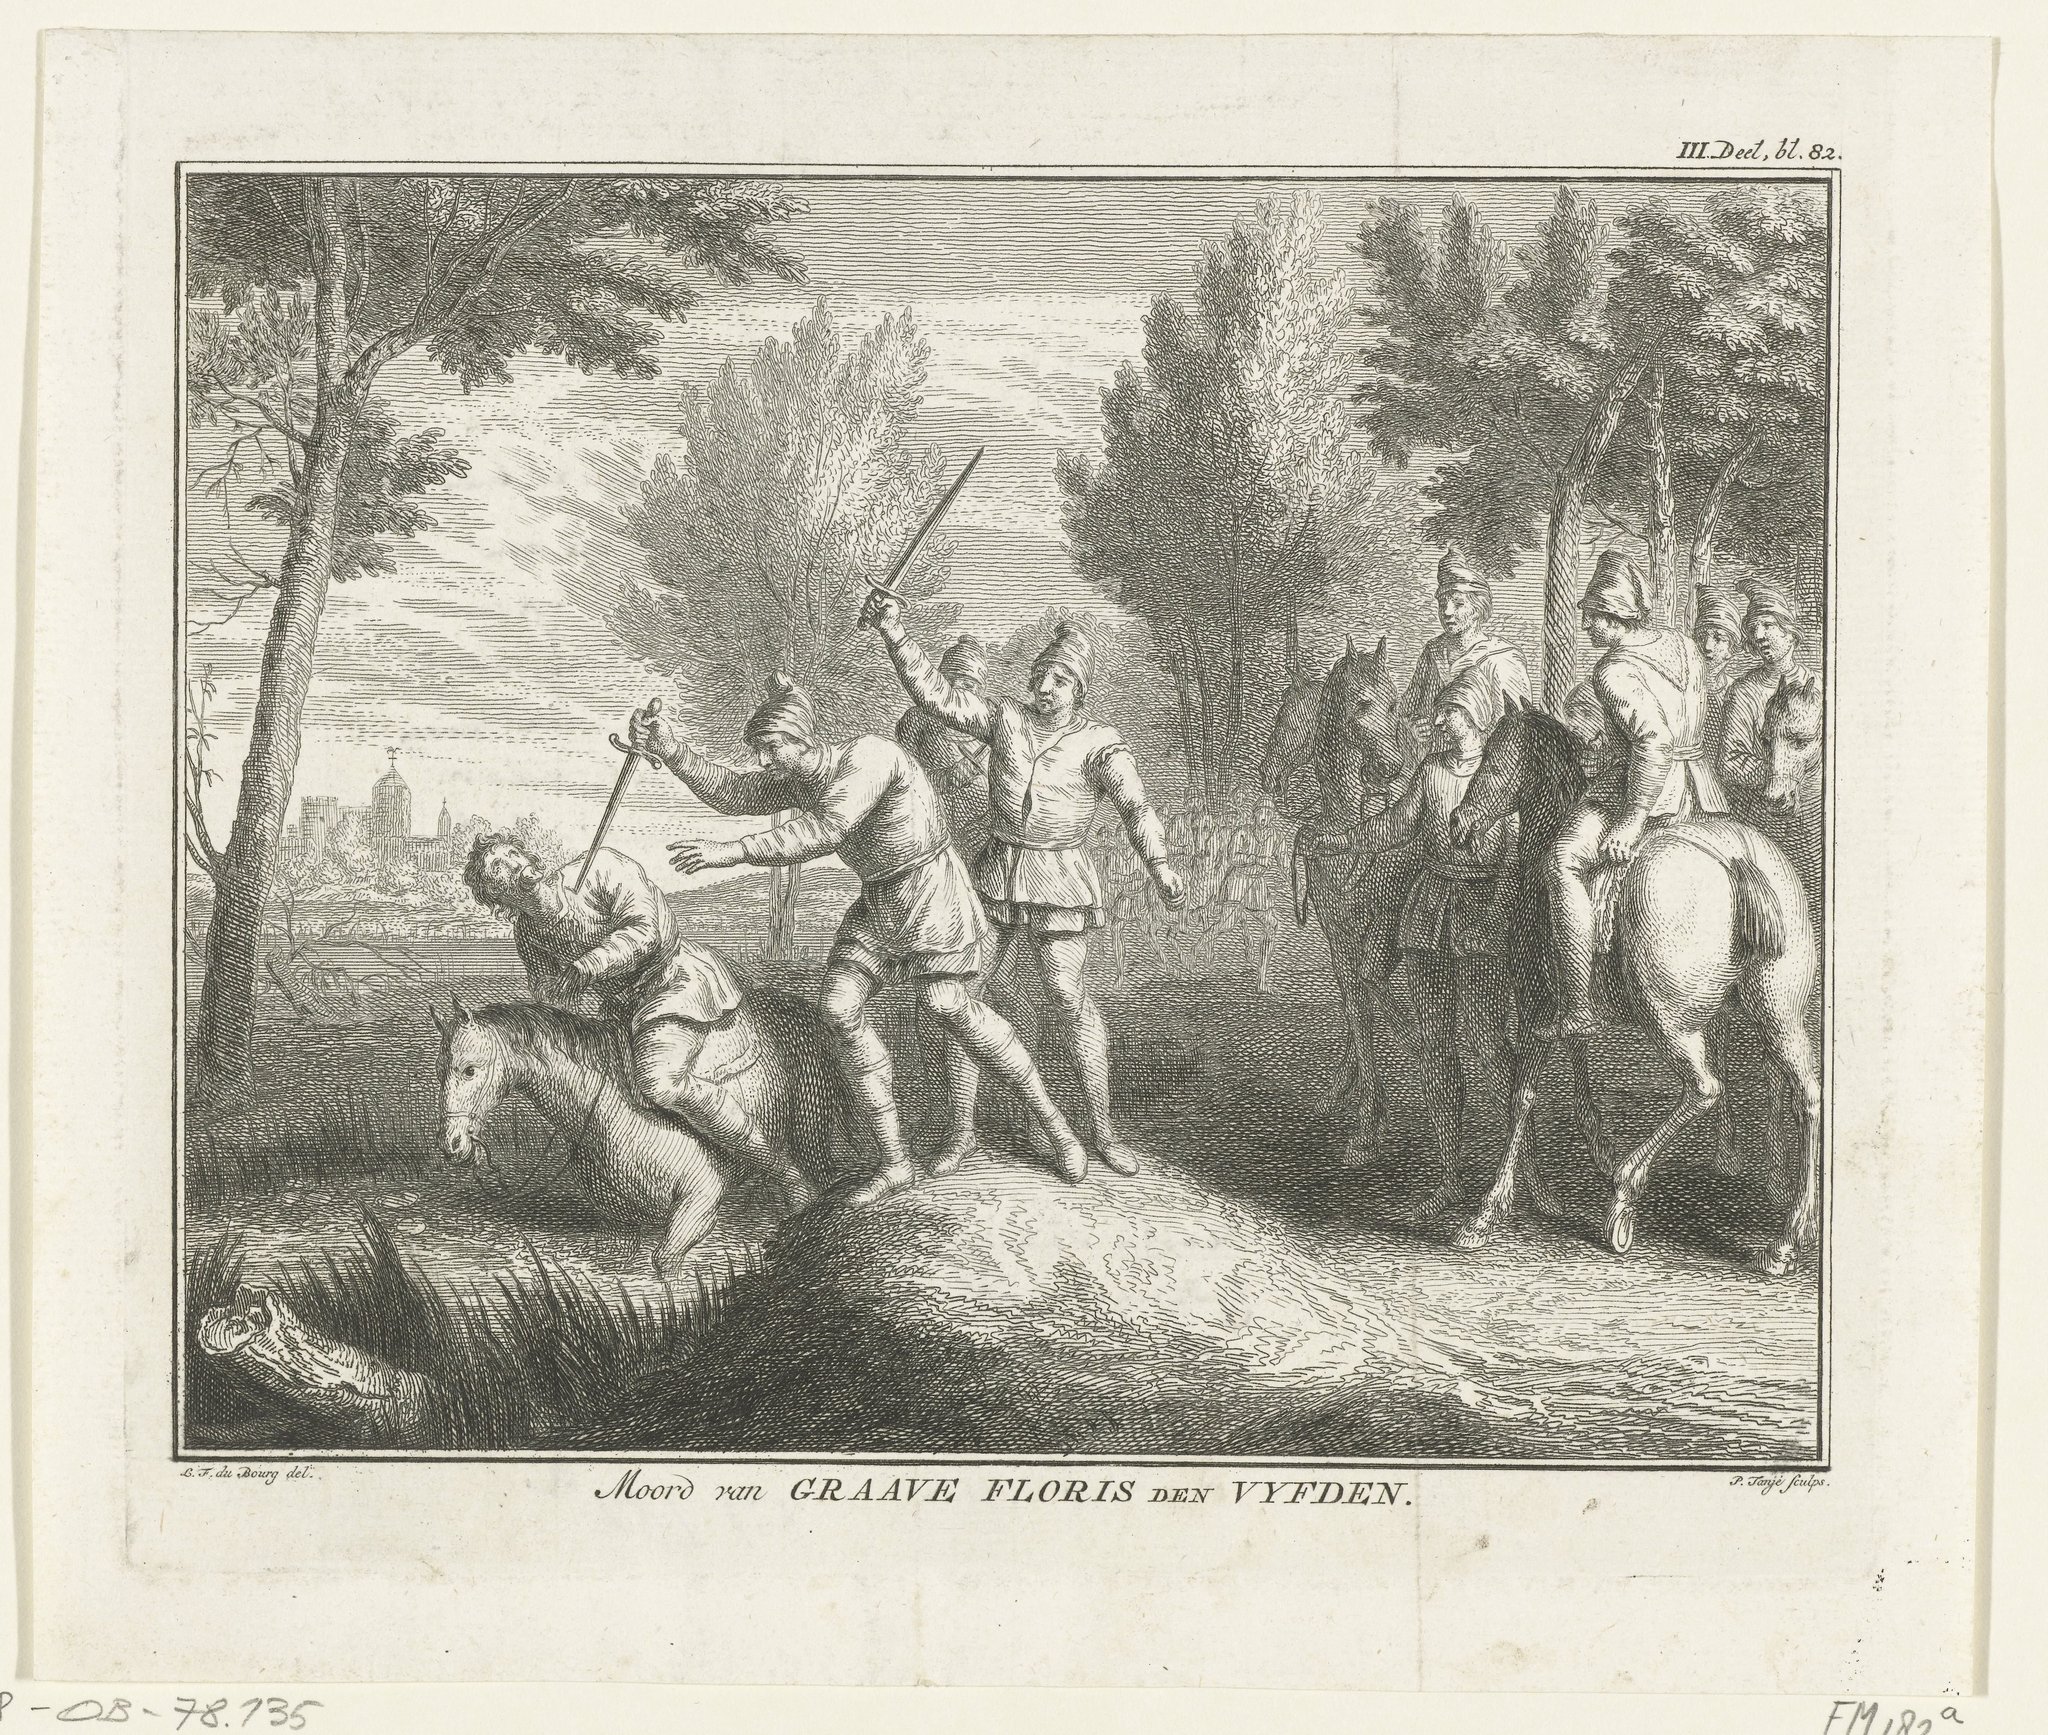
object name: print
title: Moord van Graave Floris den Vyfden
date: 1747-1759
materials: paper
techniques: etching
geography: northern netherlands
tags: leiden, floris v (graaf van holland en zeeland), violent death, being killed; being mishandled and maltreated; seeking death, netherlands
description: Floris V vermoord door Gerard van Velzen, 26 juni 1296. De graaf die vastgebonden op zijn paard zit wordt door Gerard van Velzen met een zwaard gedood.